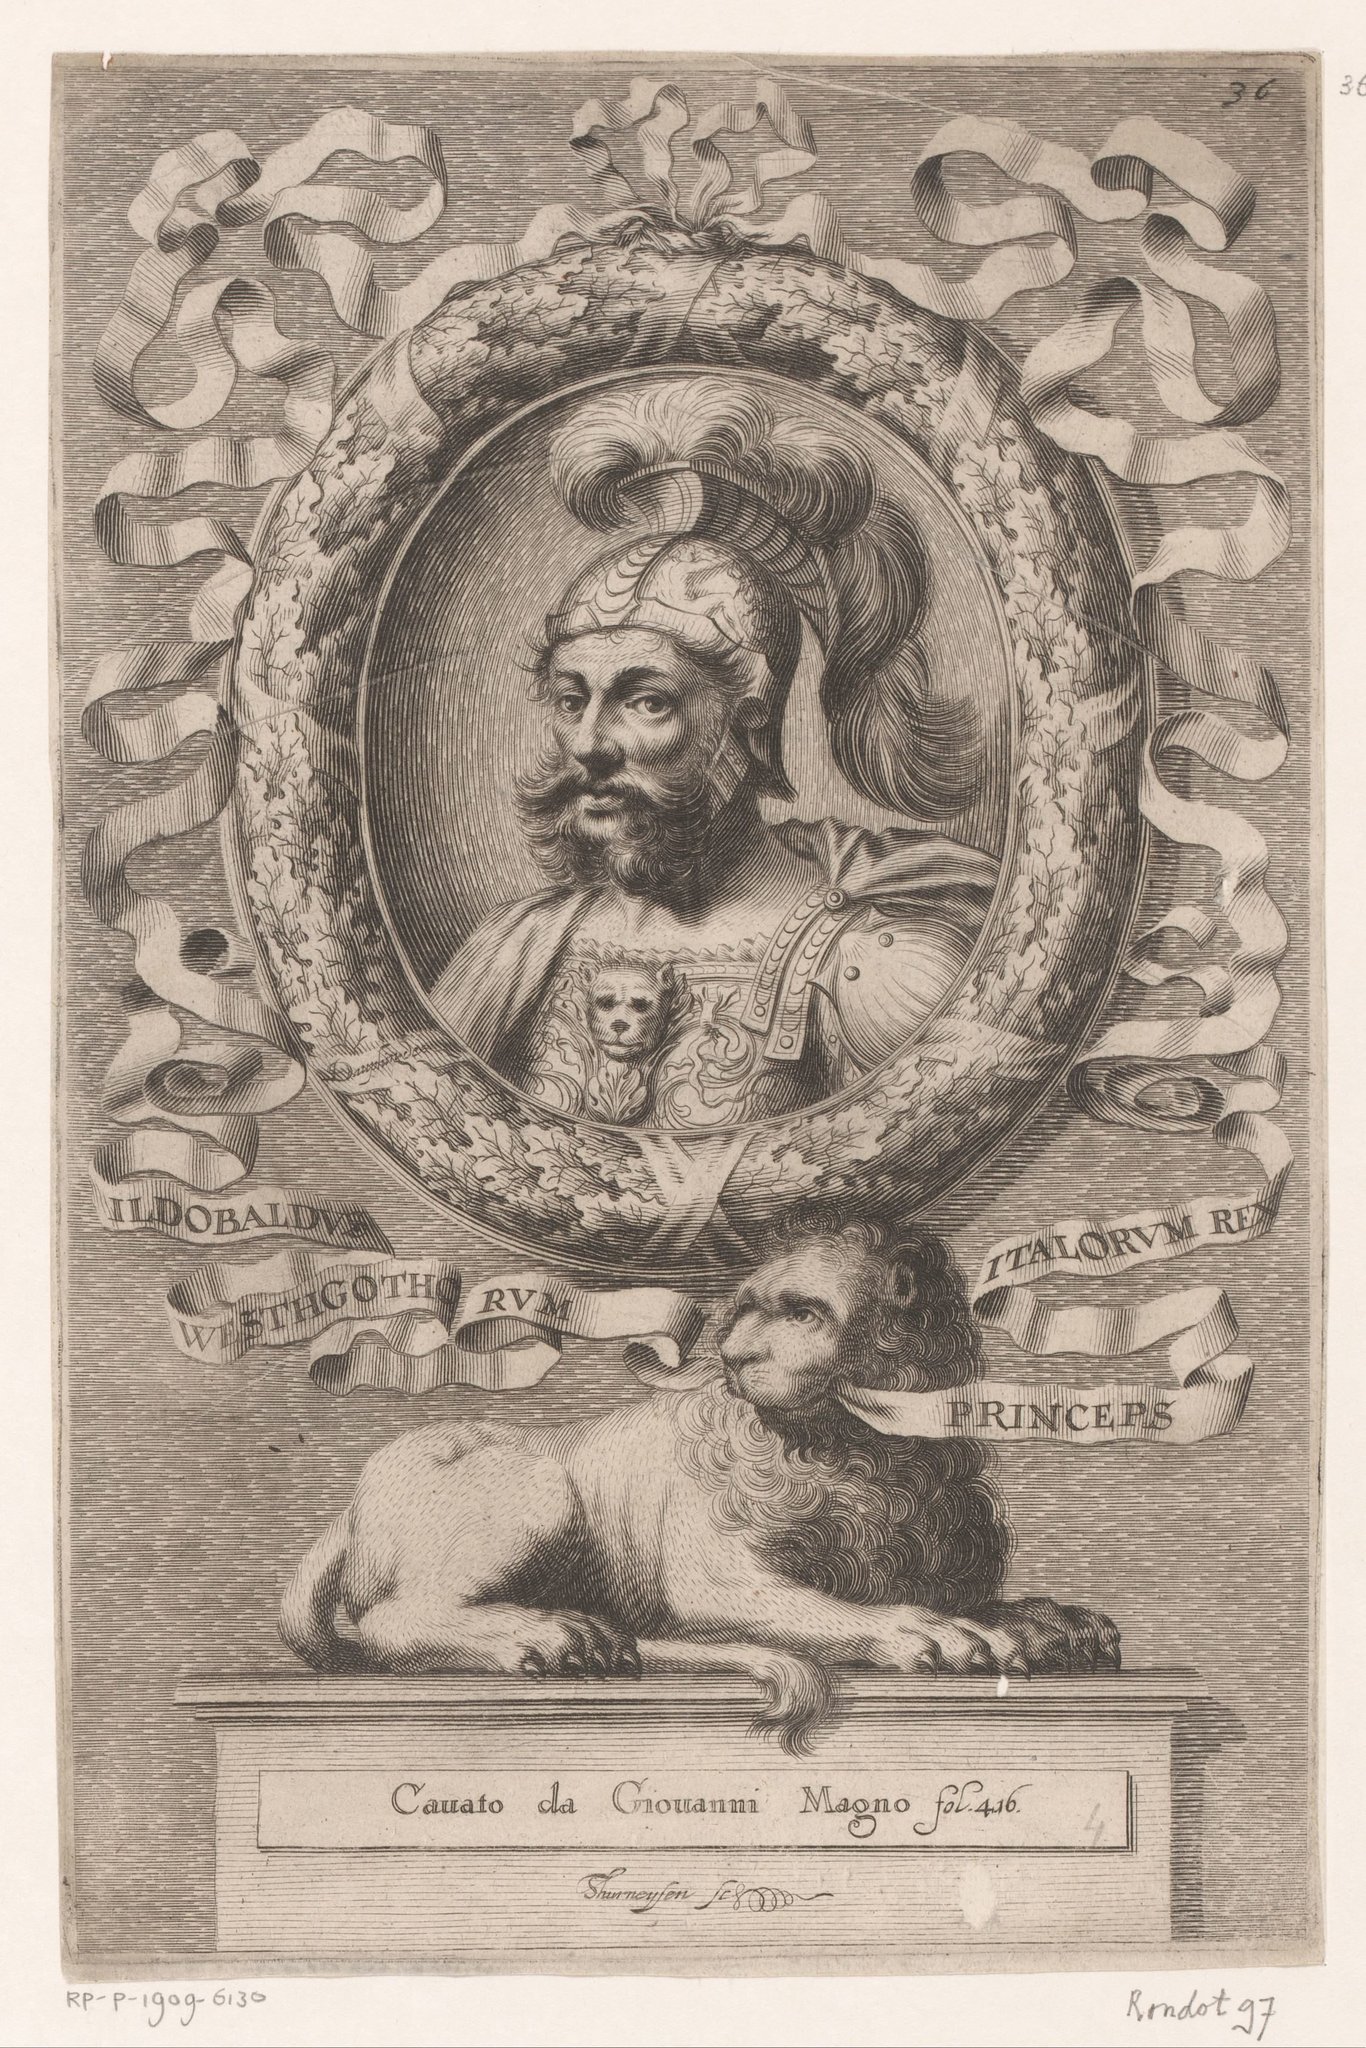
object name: book illustration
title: Portret van Ildobaldo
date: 1664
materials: paper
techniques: engraving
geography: turin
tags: helmet, historical persons, beasts of prey, predatory animals: lion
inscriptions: collector's mark: Lugt 2228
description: Prent afkomstig uit publicatie: Tesauro, Emanuele. Del regno d'Italia sotto i barbari epitome. Turijn: Bartolomeo Zavatta, 1664, p. 36.